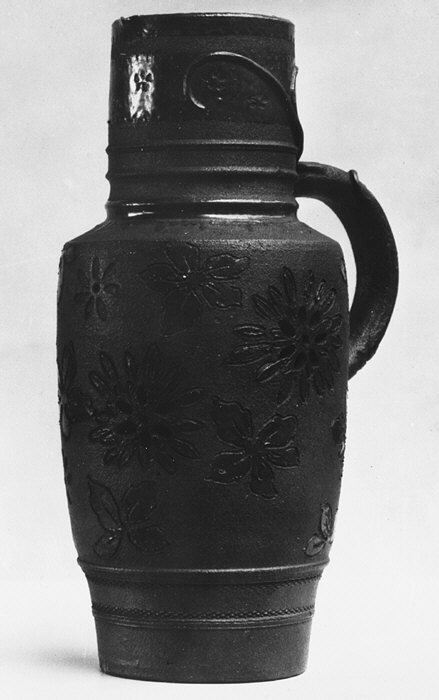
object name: jug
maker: haviland & co.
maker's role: manufactory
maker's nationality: american and french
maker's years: 1864-1931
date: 1882-1886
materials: stoneware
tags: flowers